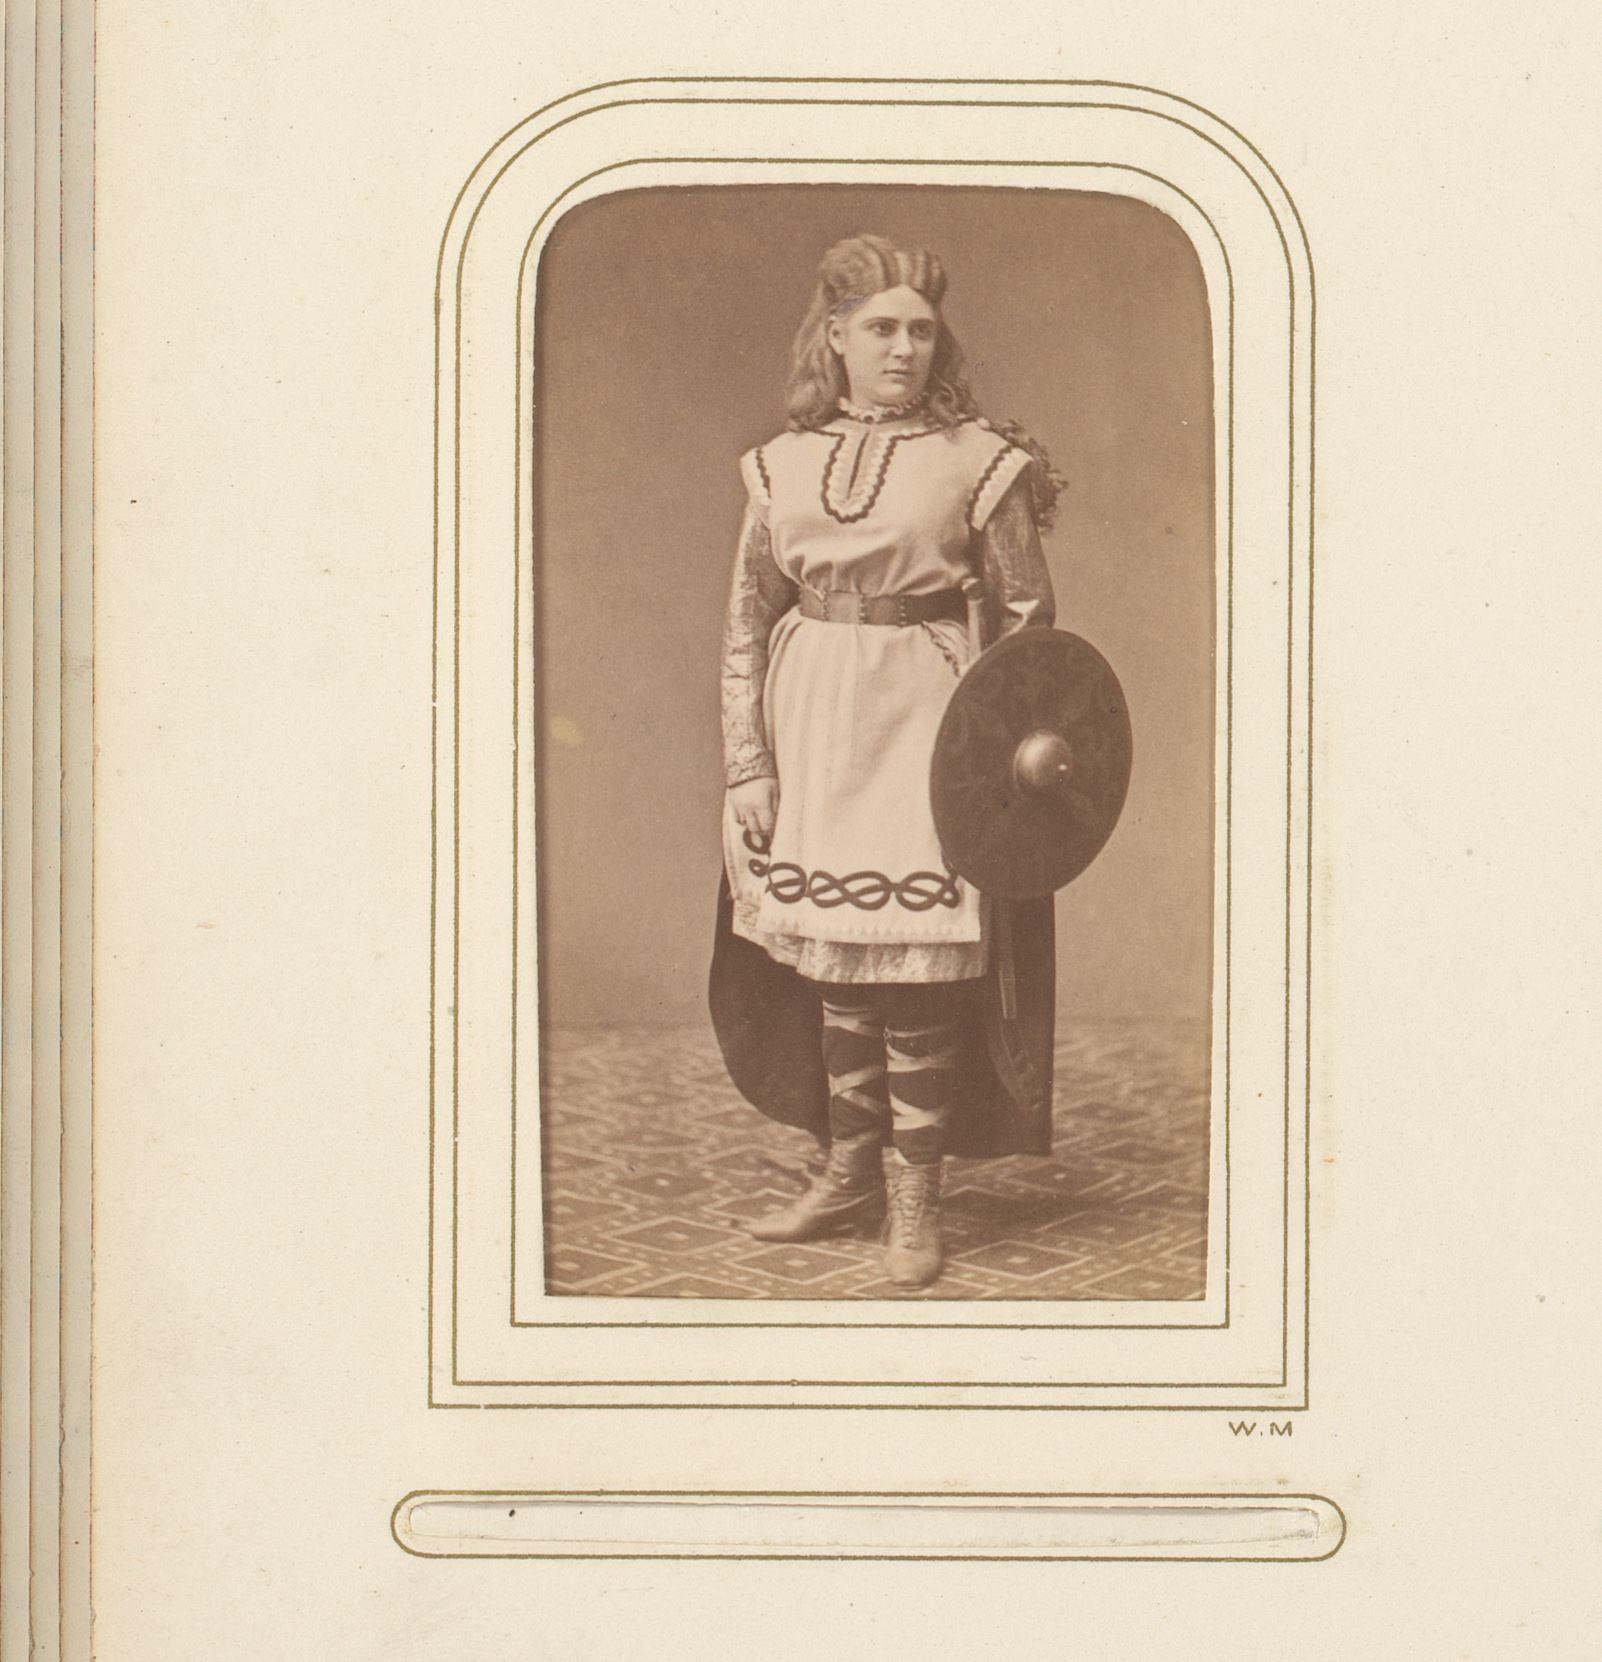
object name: photograph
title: Portret van Wilhelmina Strandberg in kostuum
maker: augusta zetterling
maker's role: fotograaf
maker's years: 1840-1898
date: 1863-1880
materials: cardboard, photographic support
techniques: albumen print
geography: stockholm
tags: stage costume, historical persons - bb - woman, portrait of opera-singer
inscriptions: inscription: ‘Augusta Zetterling/ jödd Böhme/ Stockholm/ Norra Smedjegatan No. 5’, annotation: ‘Wilhelmina Strandberg/ b. Söhrling/ 1845 / 1914’